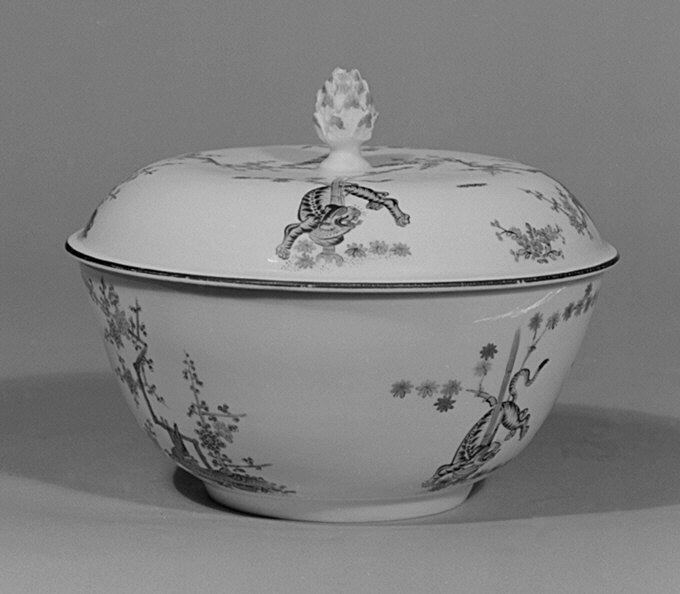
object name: bowl with cover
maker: meissen manufactory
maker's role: manufactory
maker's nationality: german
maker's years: 1710-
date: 1725-1730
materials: hard paste porcelain